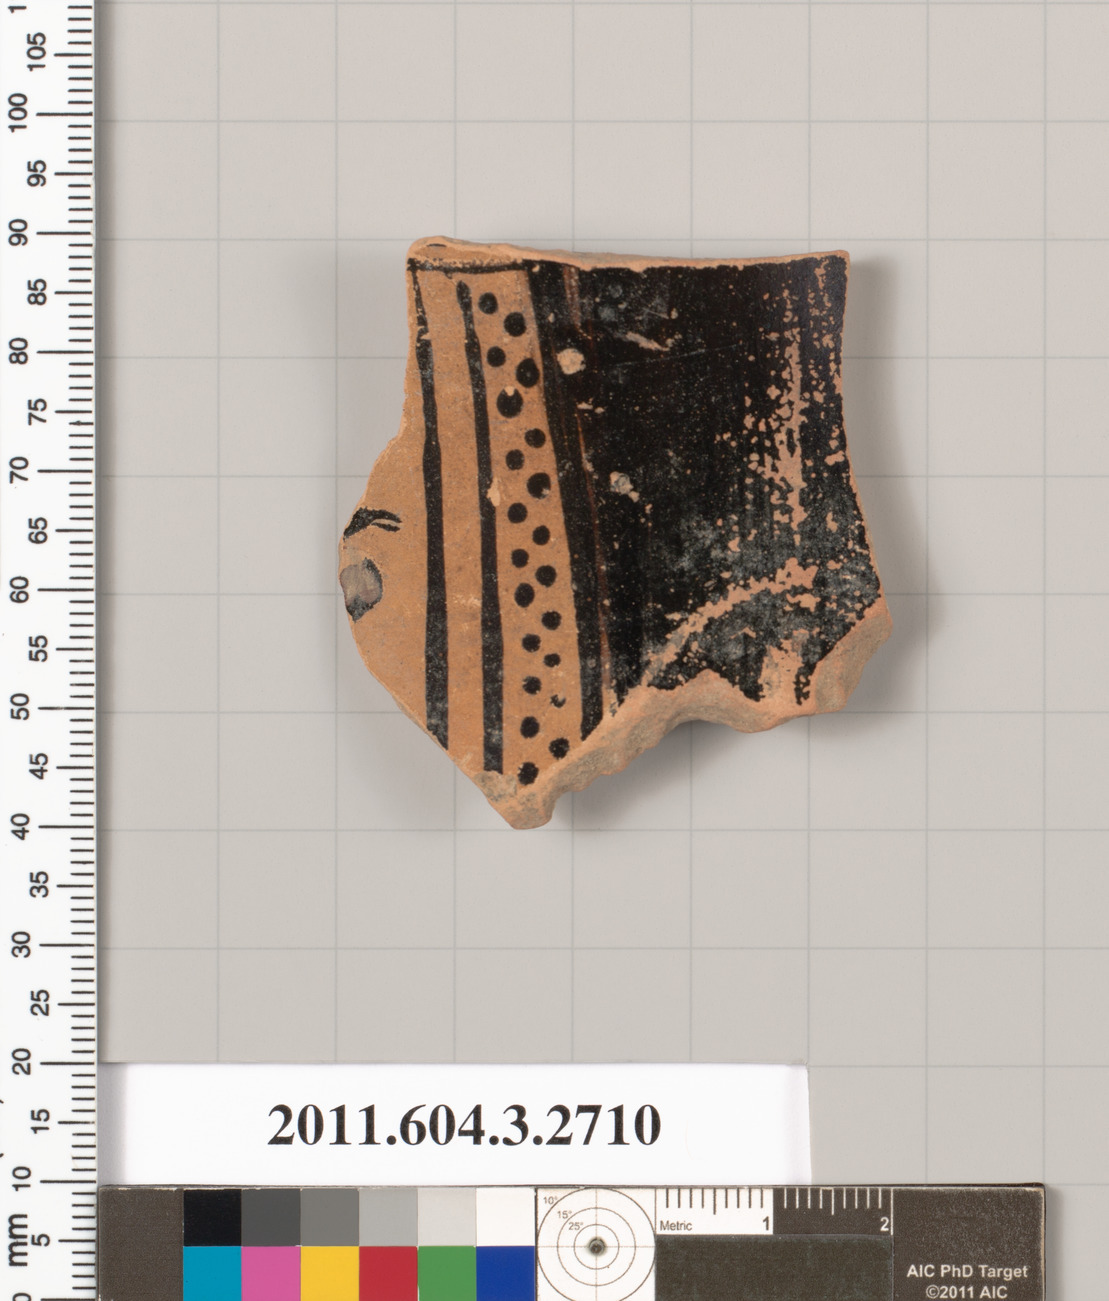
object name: olpe fragment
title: Terracotta fragment of an olpe (jug)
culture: greek, attic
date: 534-468 BCE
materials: terracotta